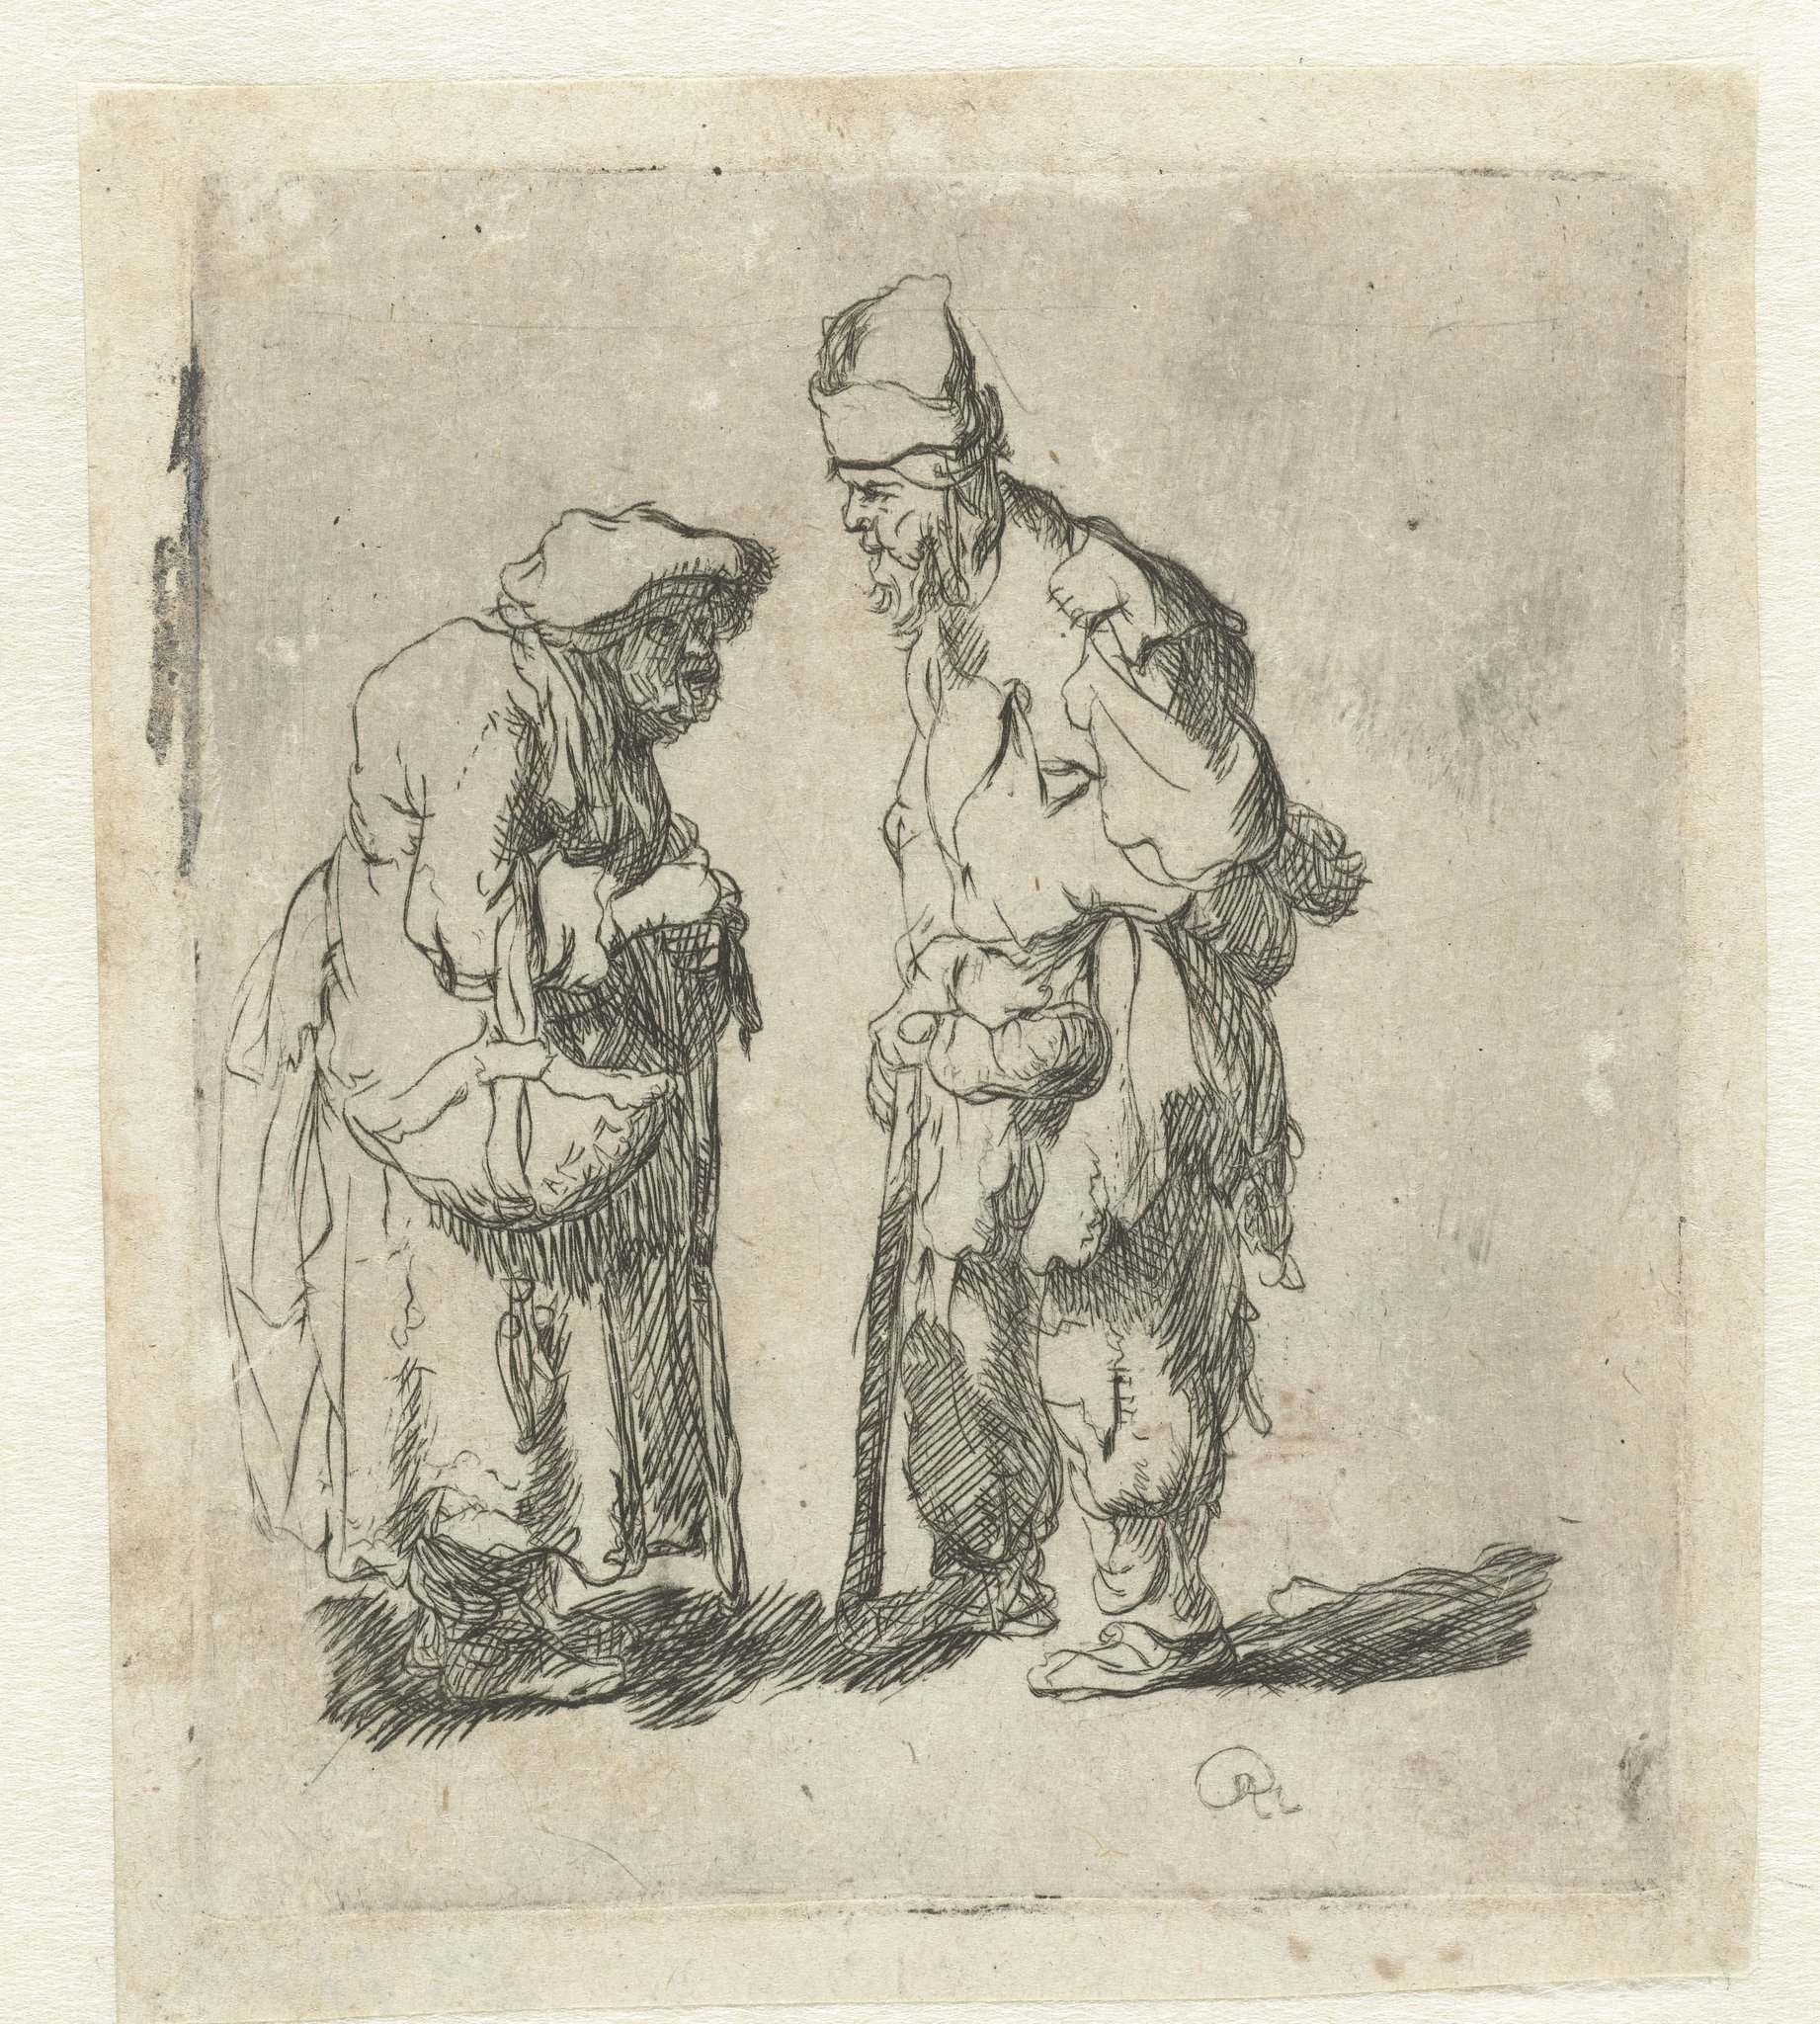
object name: print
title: Beggar man and beggar woman conversing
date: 1630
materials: paper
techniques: etching, intaglio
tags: beggar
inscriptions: collector's mark: Lugt 240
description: Spiegelbeeldige kopie naar de gelijknamige prent van Rembrandt.